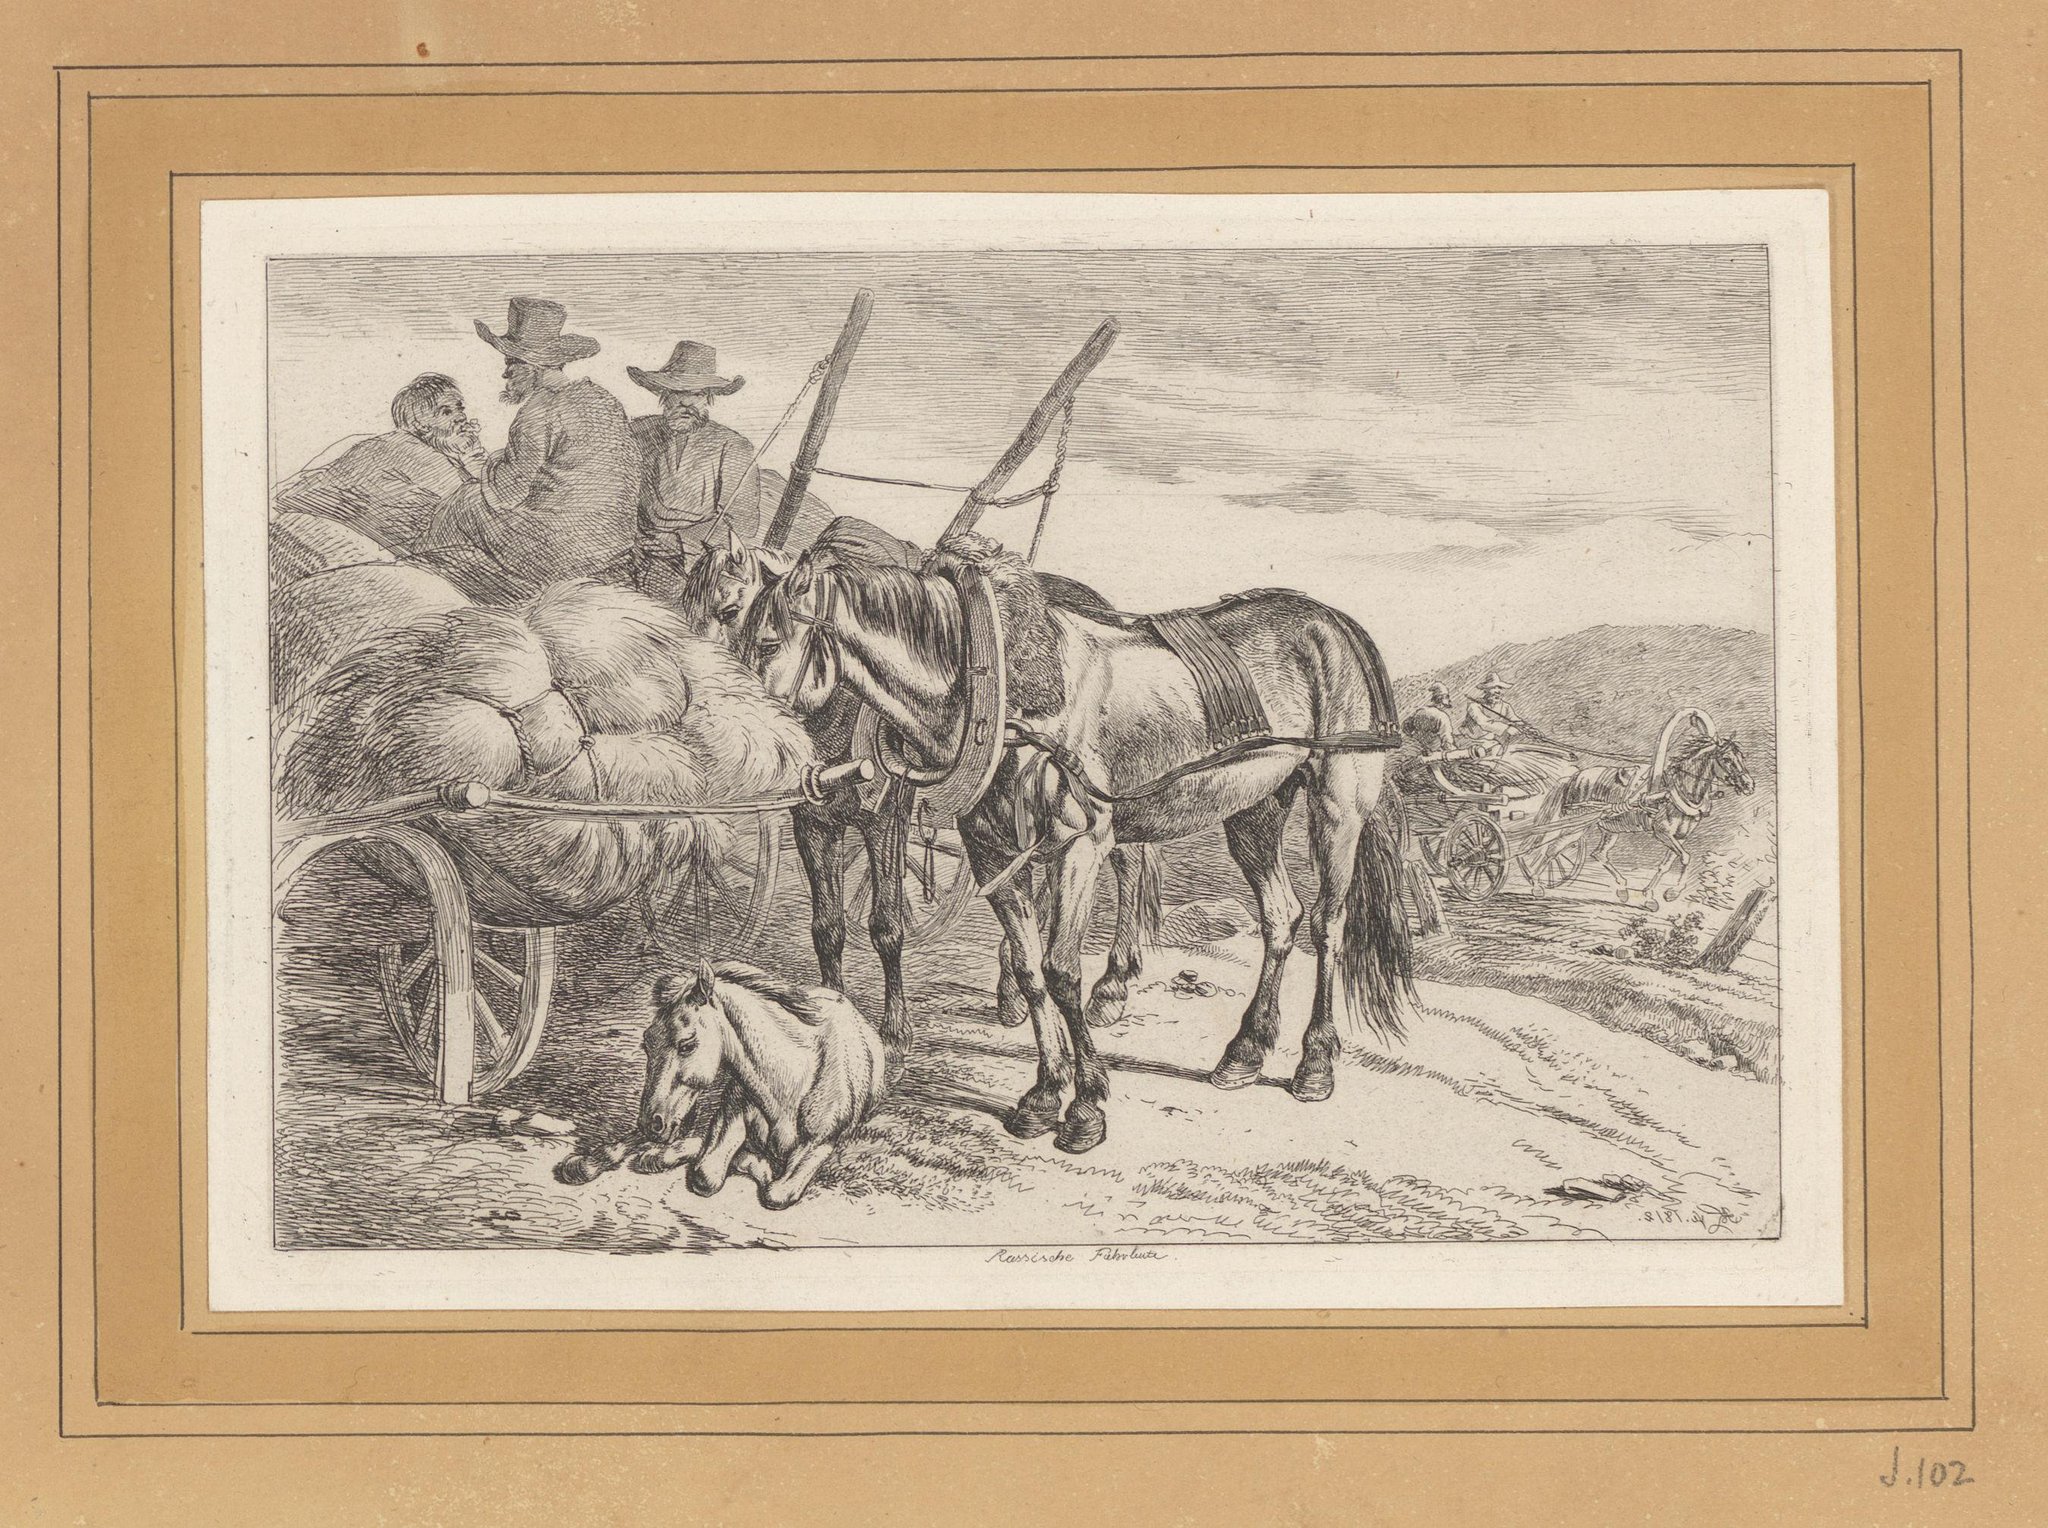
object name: print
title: Russischer Fuhrleute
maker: johann adam klein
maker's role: draughtsman, print maker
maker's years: 1792-1875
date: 1812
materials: paper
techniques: etching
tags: four-wheeled vehicle drawn by one animal, farmers, four-wheeled vehicle drawn by two animals, hay-wagon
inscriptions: : Lugt 2760, collector's mark: Lugt 2228